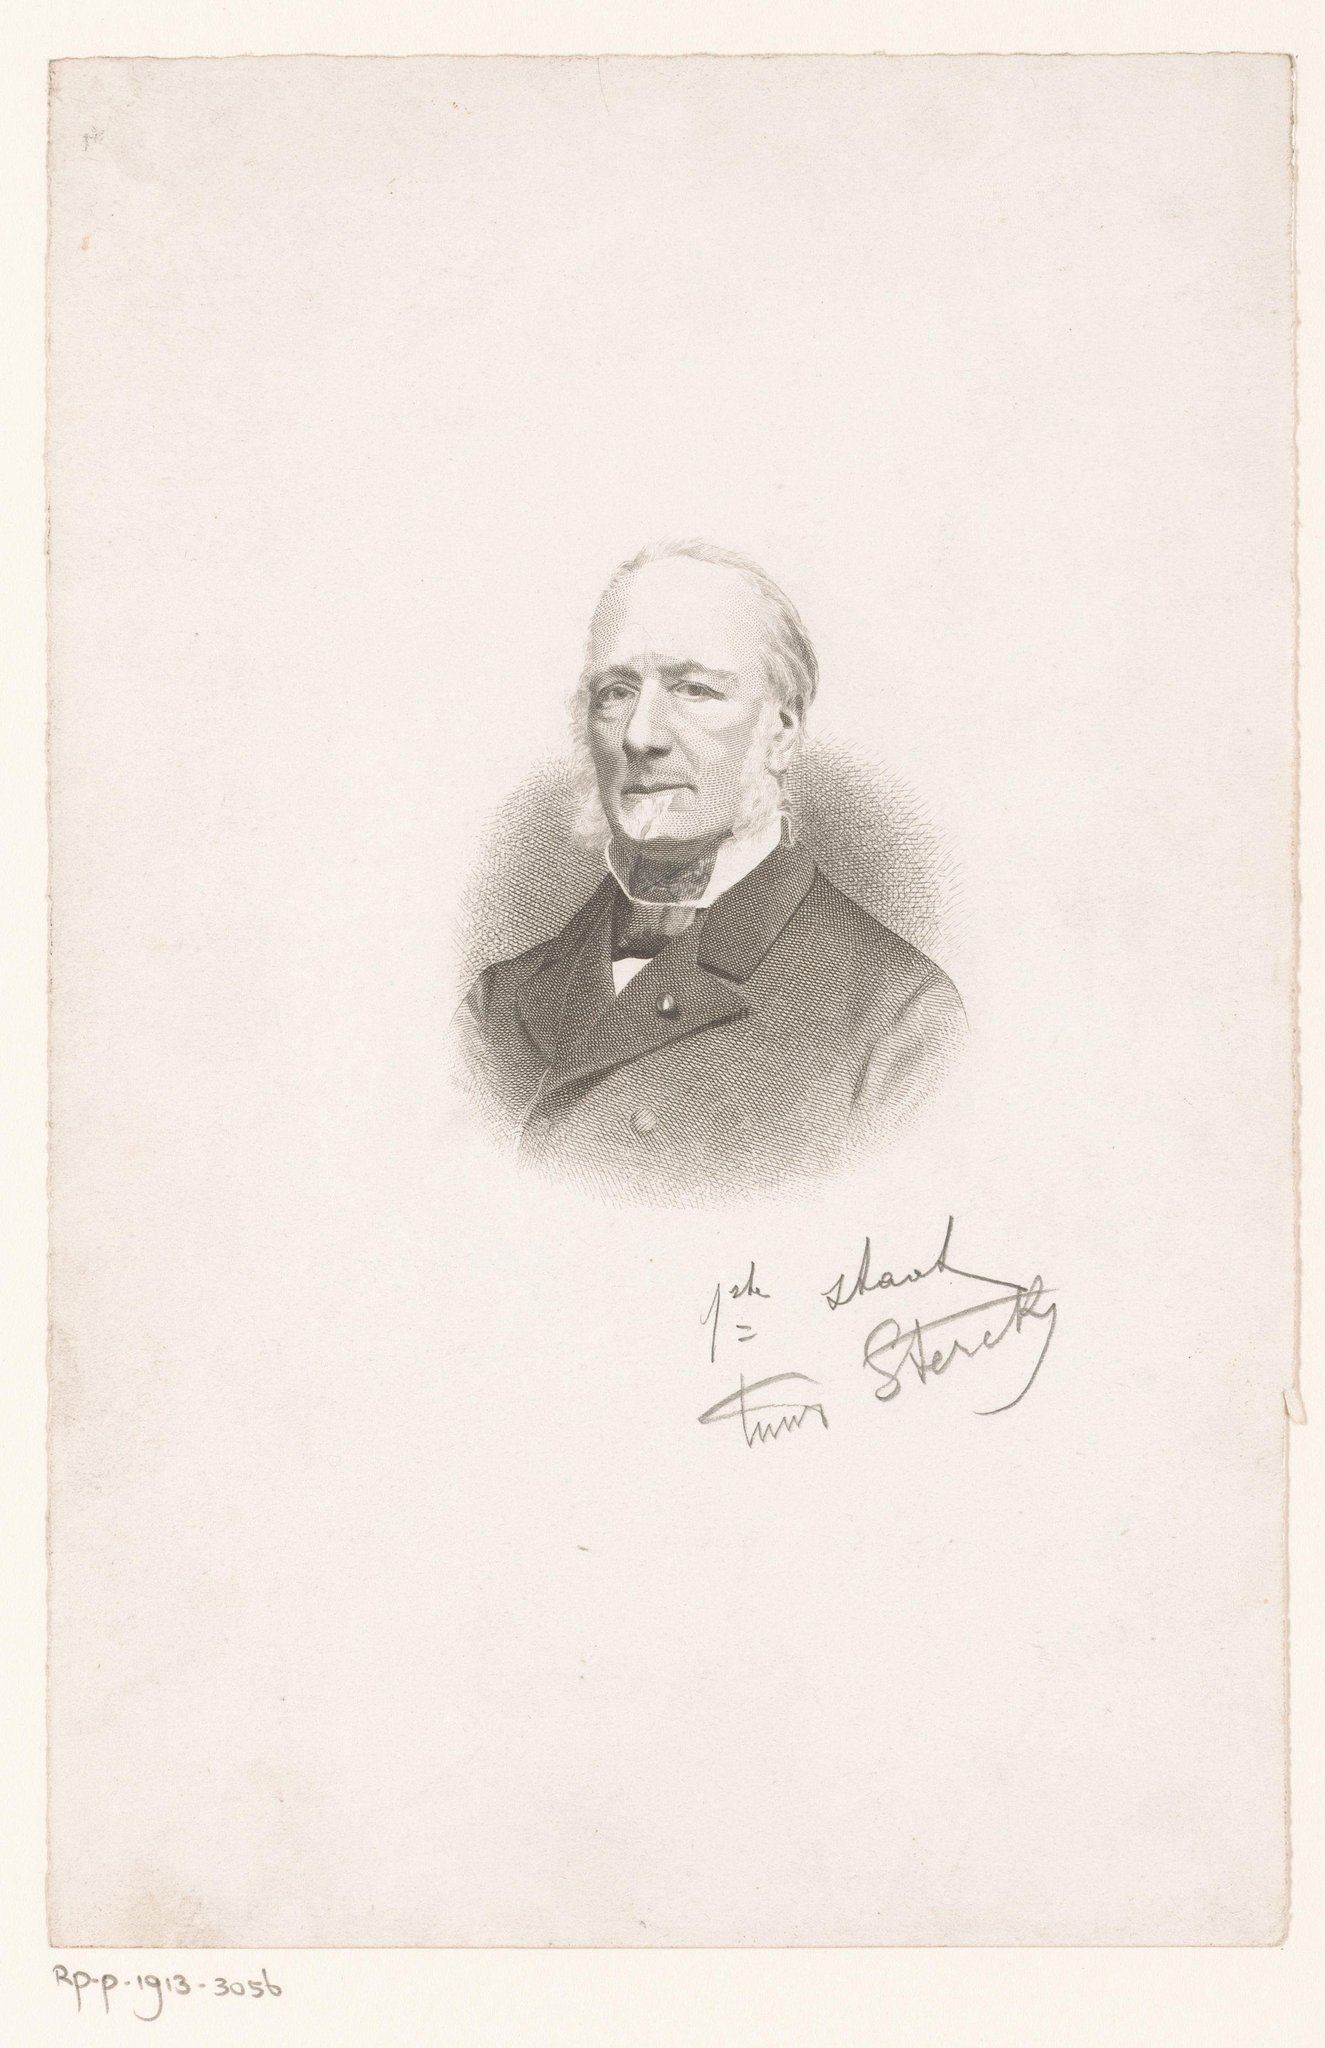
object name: print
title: Portret van Charles Louis Ruelens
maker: arthur sterck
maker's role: print maker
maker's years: 1868-1897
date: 1878-1897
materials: paper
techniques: etching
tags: historical persons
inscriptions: annotation: ‘1ste staat’, collector's mark: Lugt 2228